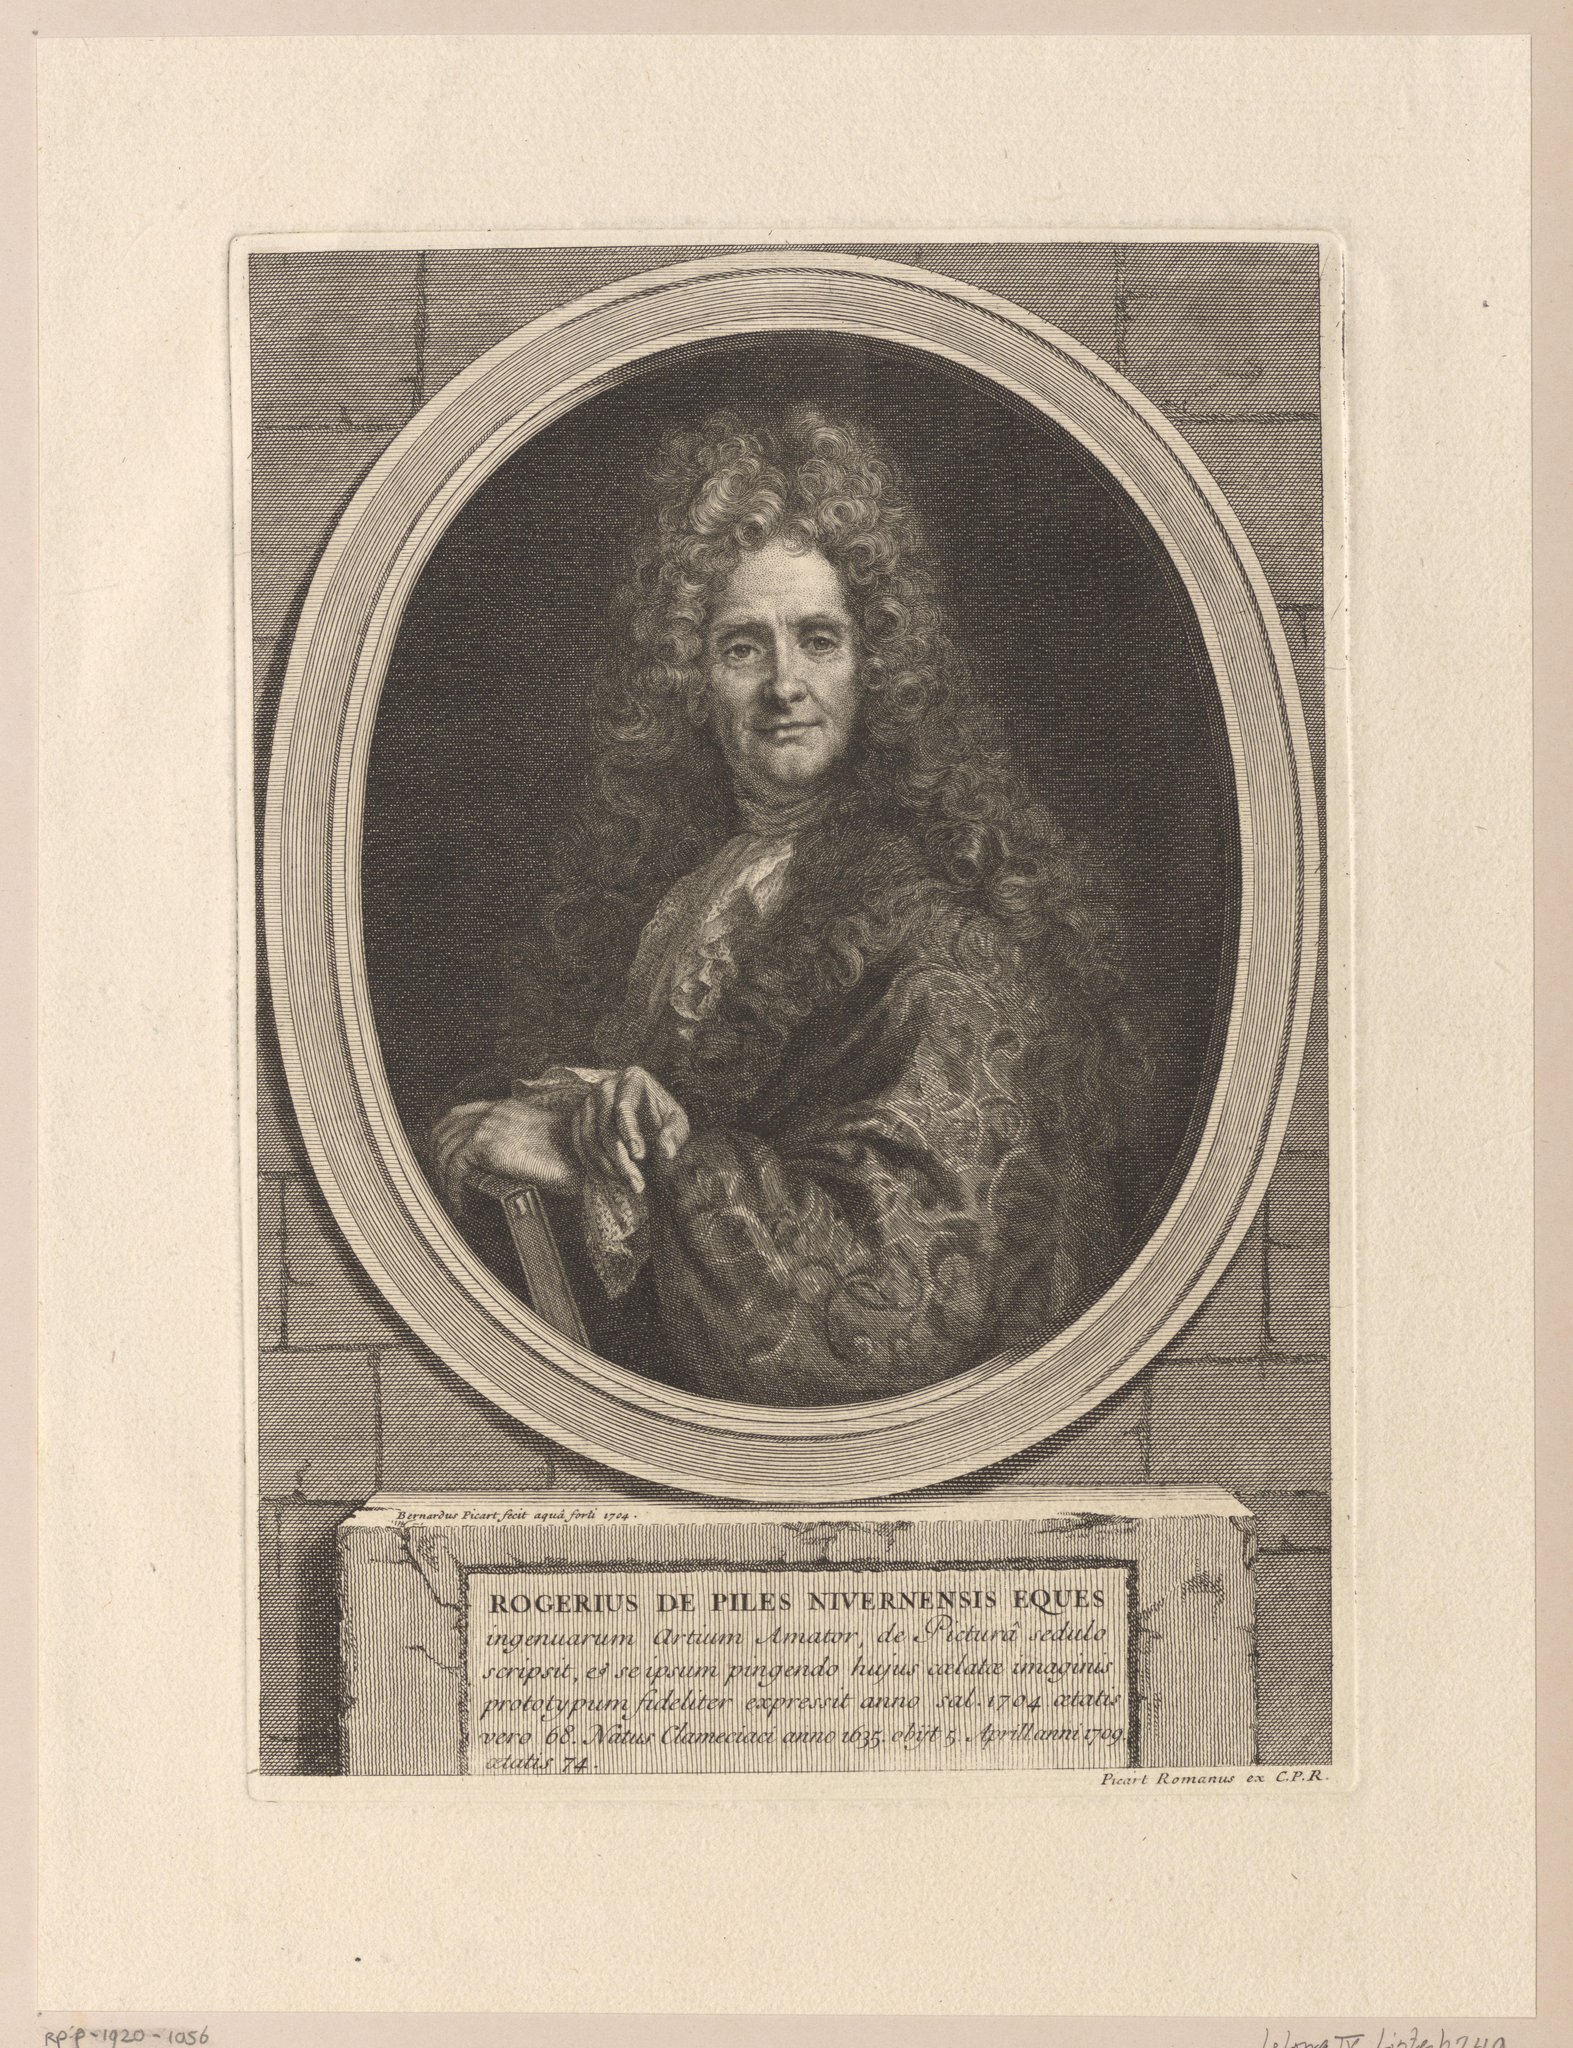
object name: print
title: Portret van Roger de Piles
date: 1709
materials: paper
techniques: engraving, etching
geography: paris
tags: print maker, draughtsman, roger de piles, historical persons, portrait of a writer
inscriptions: collector's mark: Lugt 2228